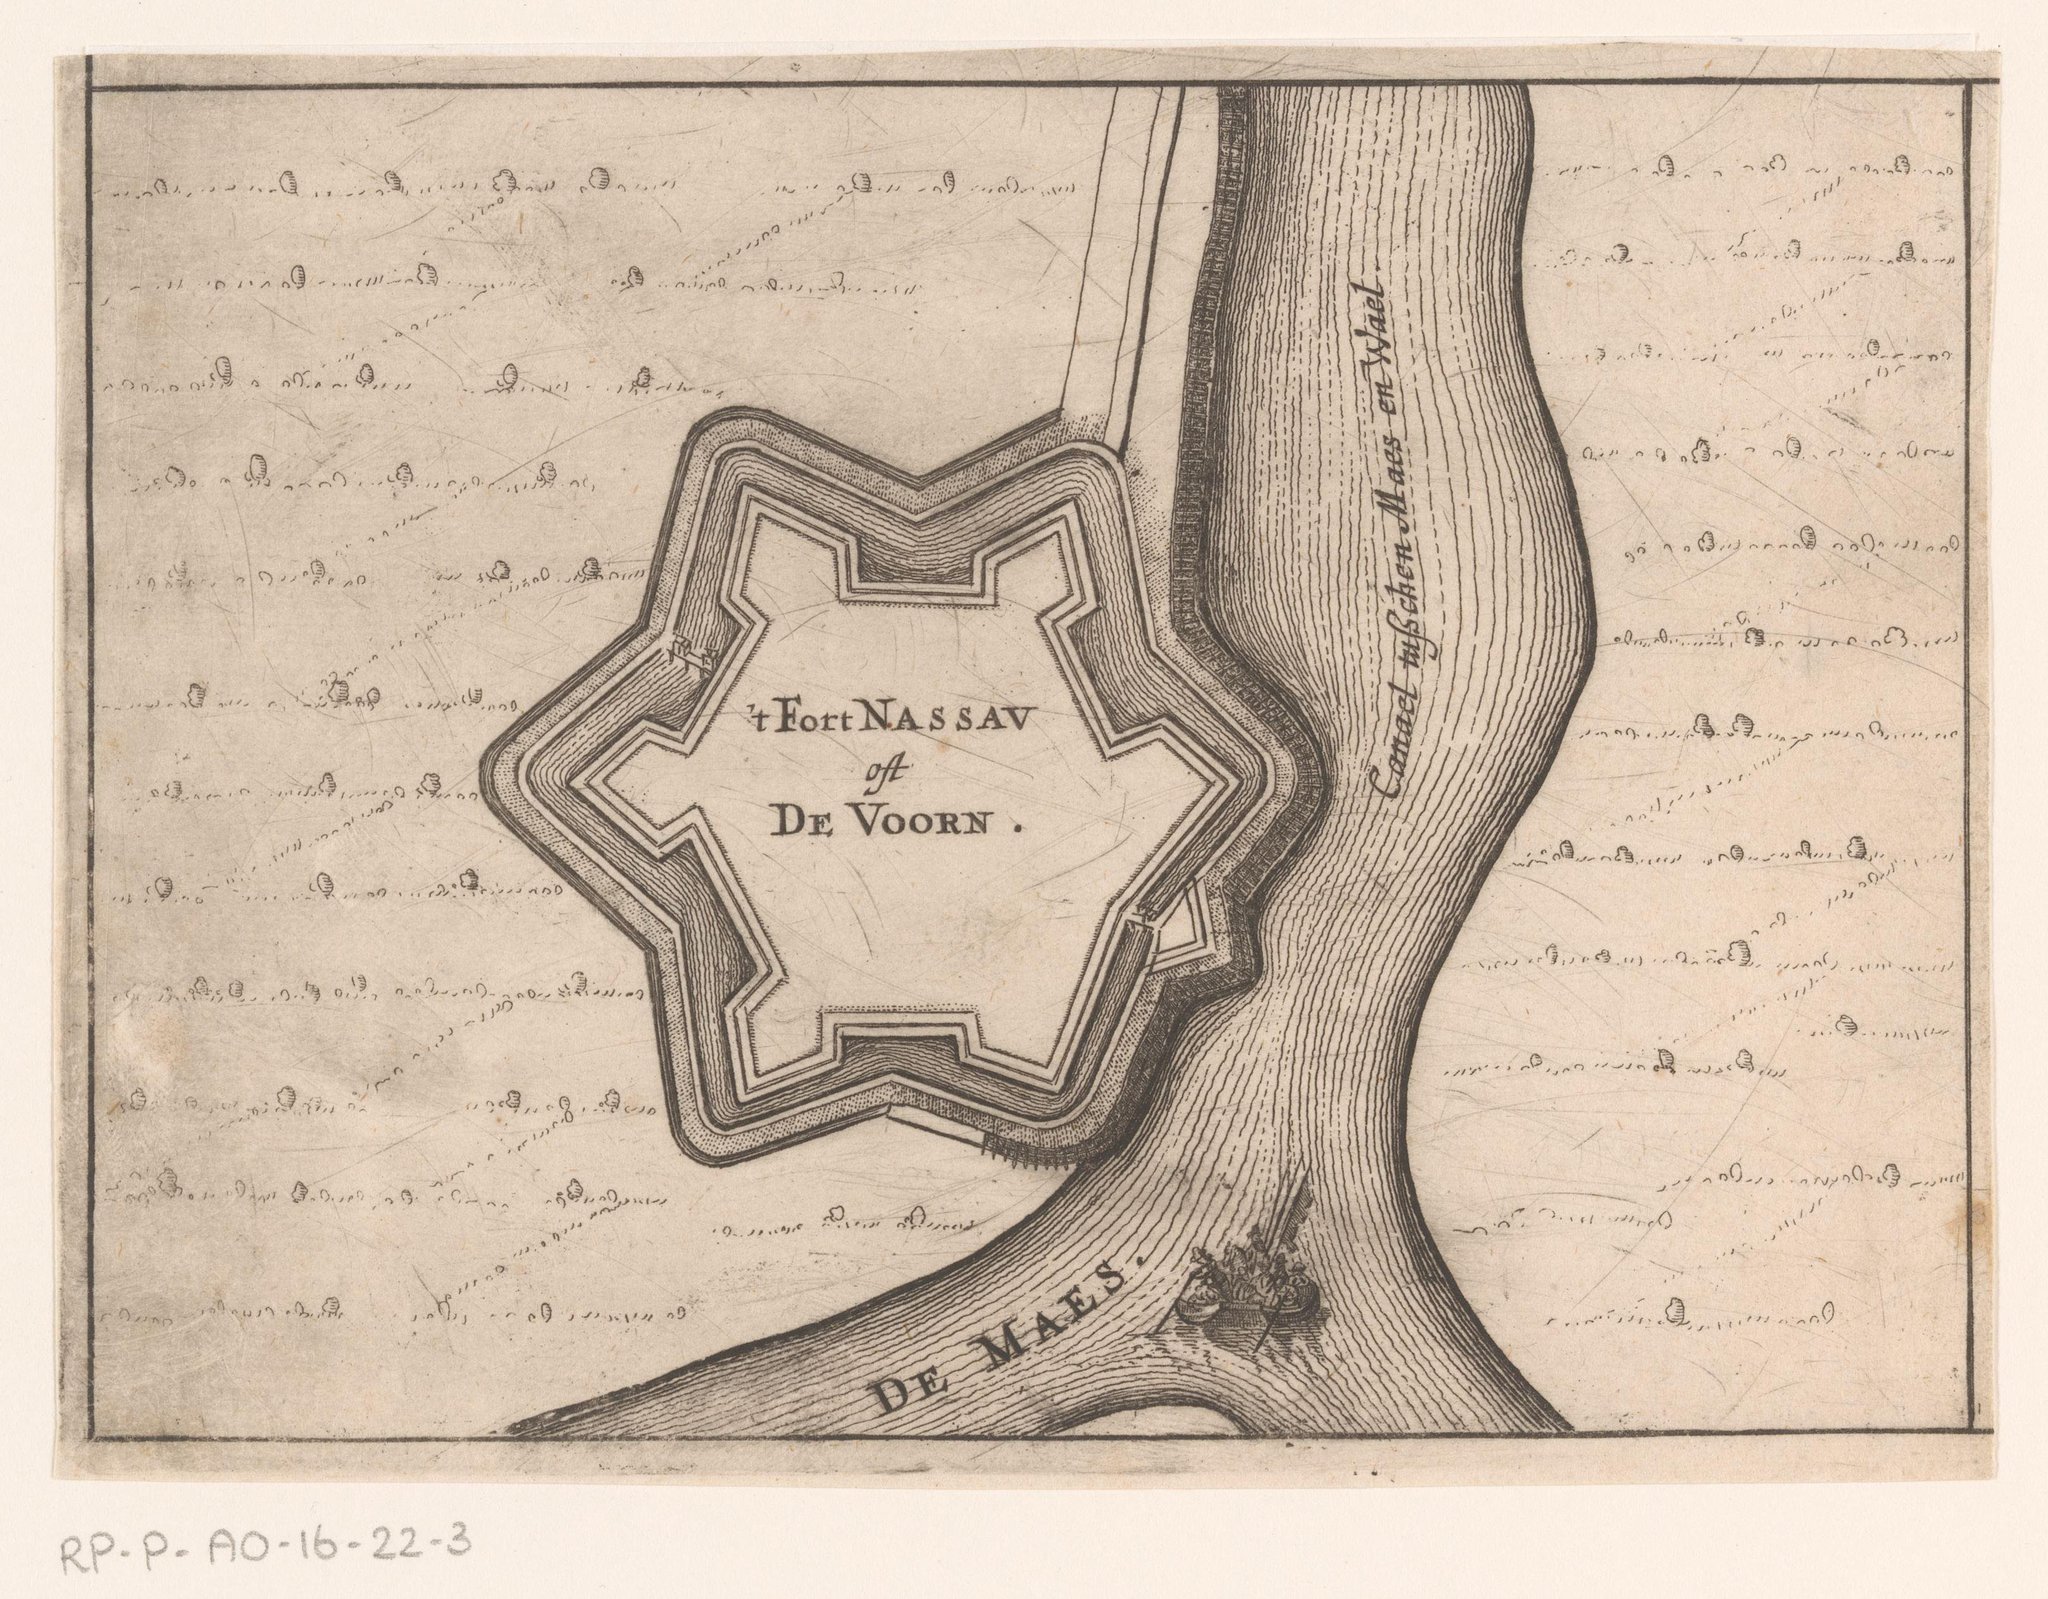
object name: print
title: Vestingplattegrond van Fort de Voorn, ook wel Fort Nassau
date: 1653-1672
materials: paper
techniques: engraving, etching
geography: arnhem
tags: ships (in general), fortified city, maps of cities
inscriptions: collector's mark: Lugt 2228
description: Prent ook gebruikt in: Van Slichtenhorst, Arend. XIV boeken van de Geldersse geschiedenissen. Arnhem: Jacob van Biesen, 1653-1654. En in: Cartes géographiques du Duché de Gueldre et Comté de Zutphen. Arnhem: Jacob van Biesen, 1672. Plattegrond oorspronkelijk van één plaat gedrukt met twee andere plattegronden, waaronder RP-P-AO-16-22-2.